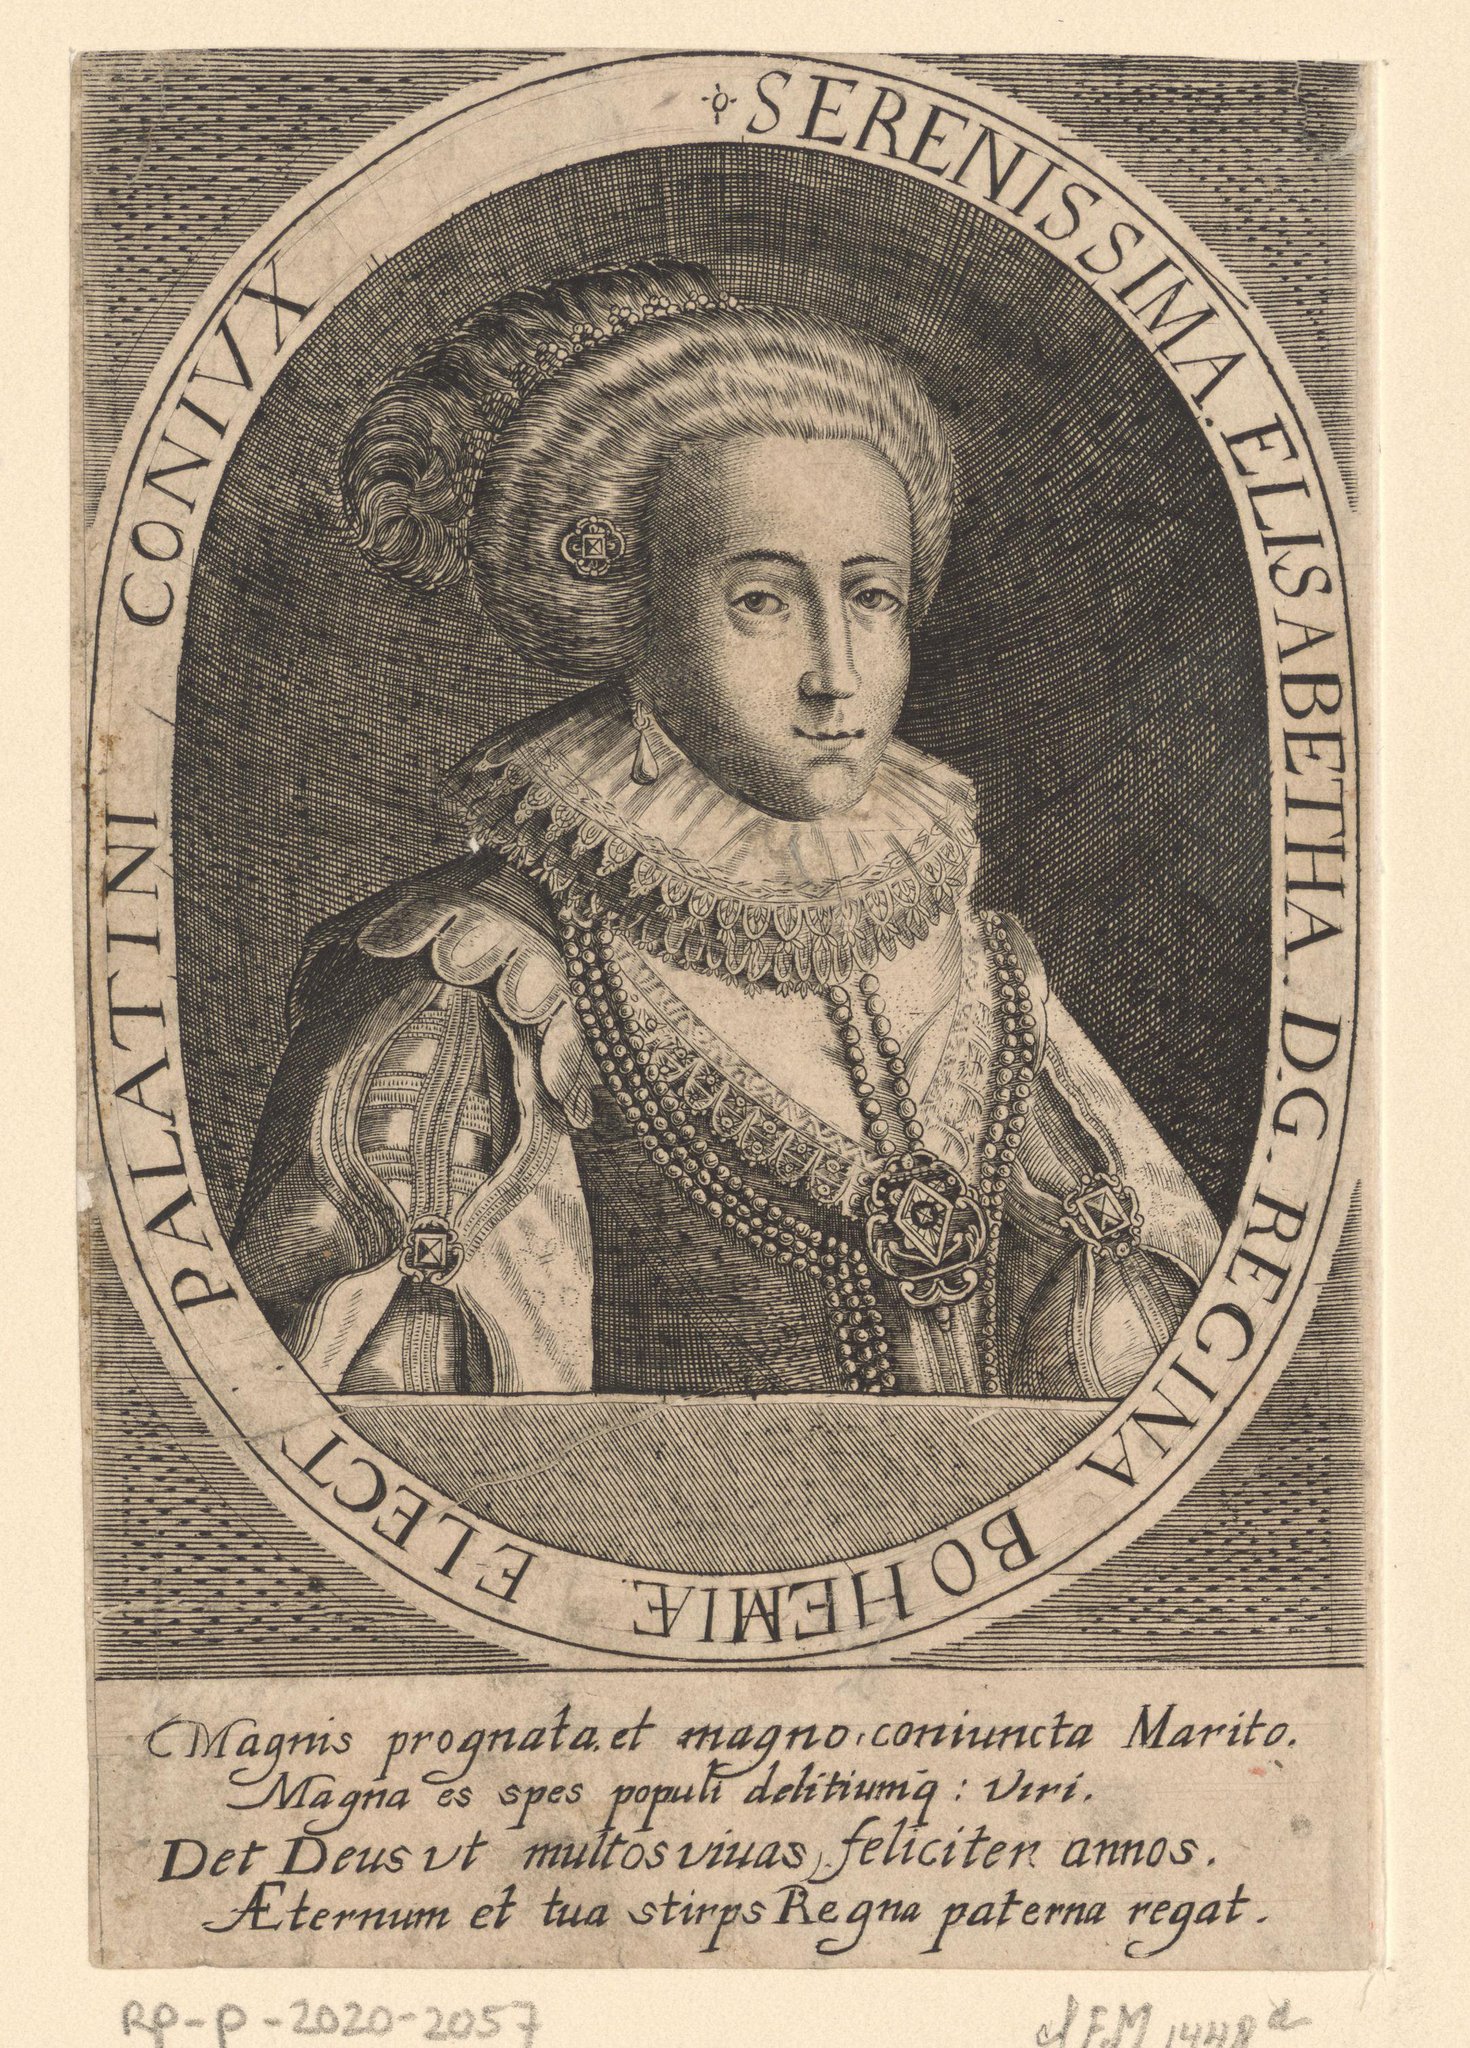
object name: print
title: Portret van Elisabeth Stuart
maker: Anonymous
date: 1619-1650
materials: paper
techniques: engraving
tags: historical persons - bb - woman, pearl; pearl necklace